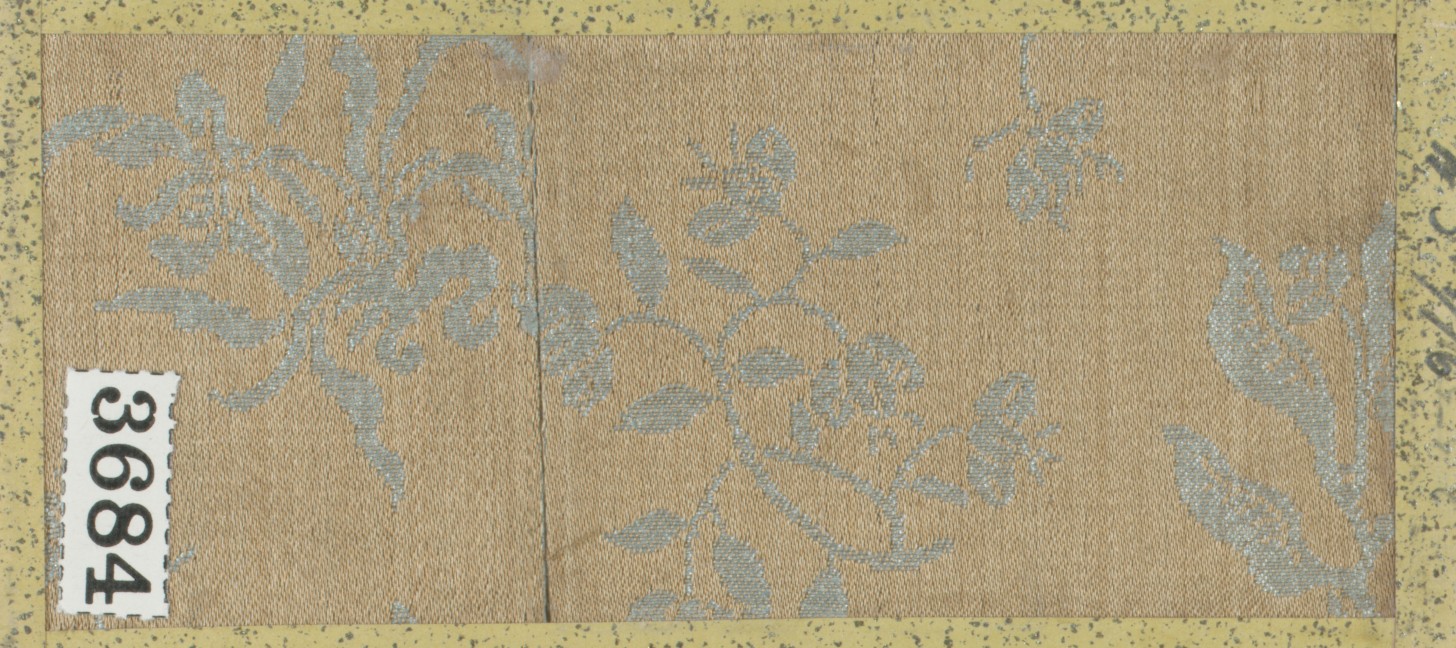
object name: sample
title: Textile Sample from Sample Book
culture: japanese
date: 1801-1900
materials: silk